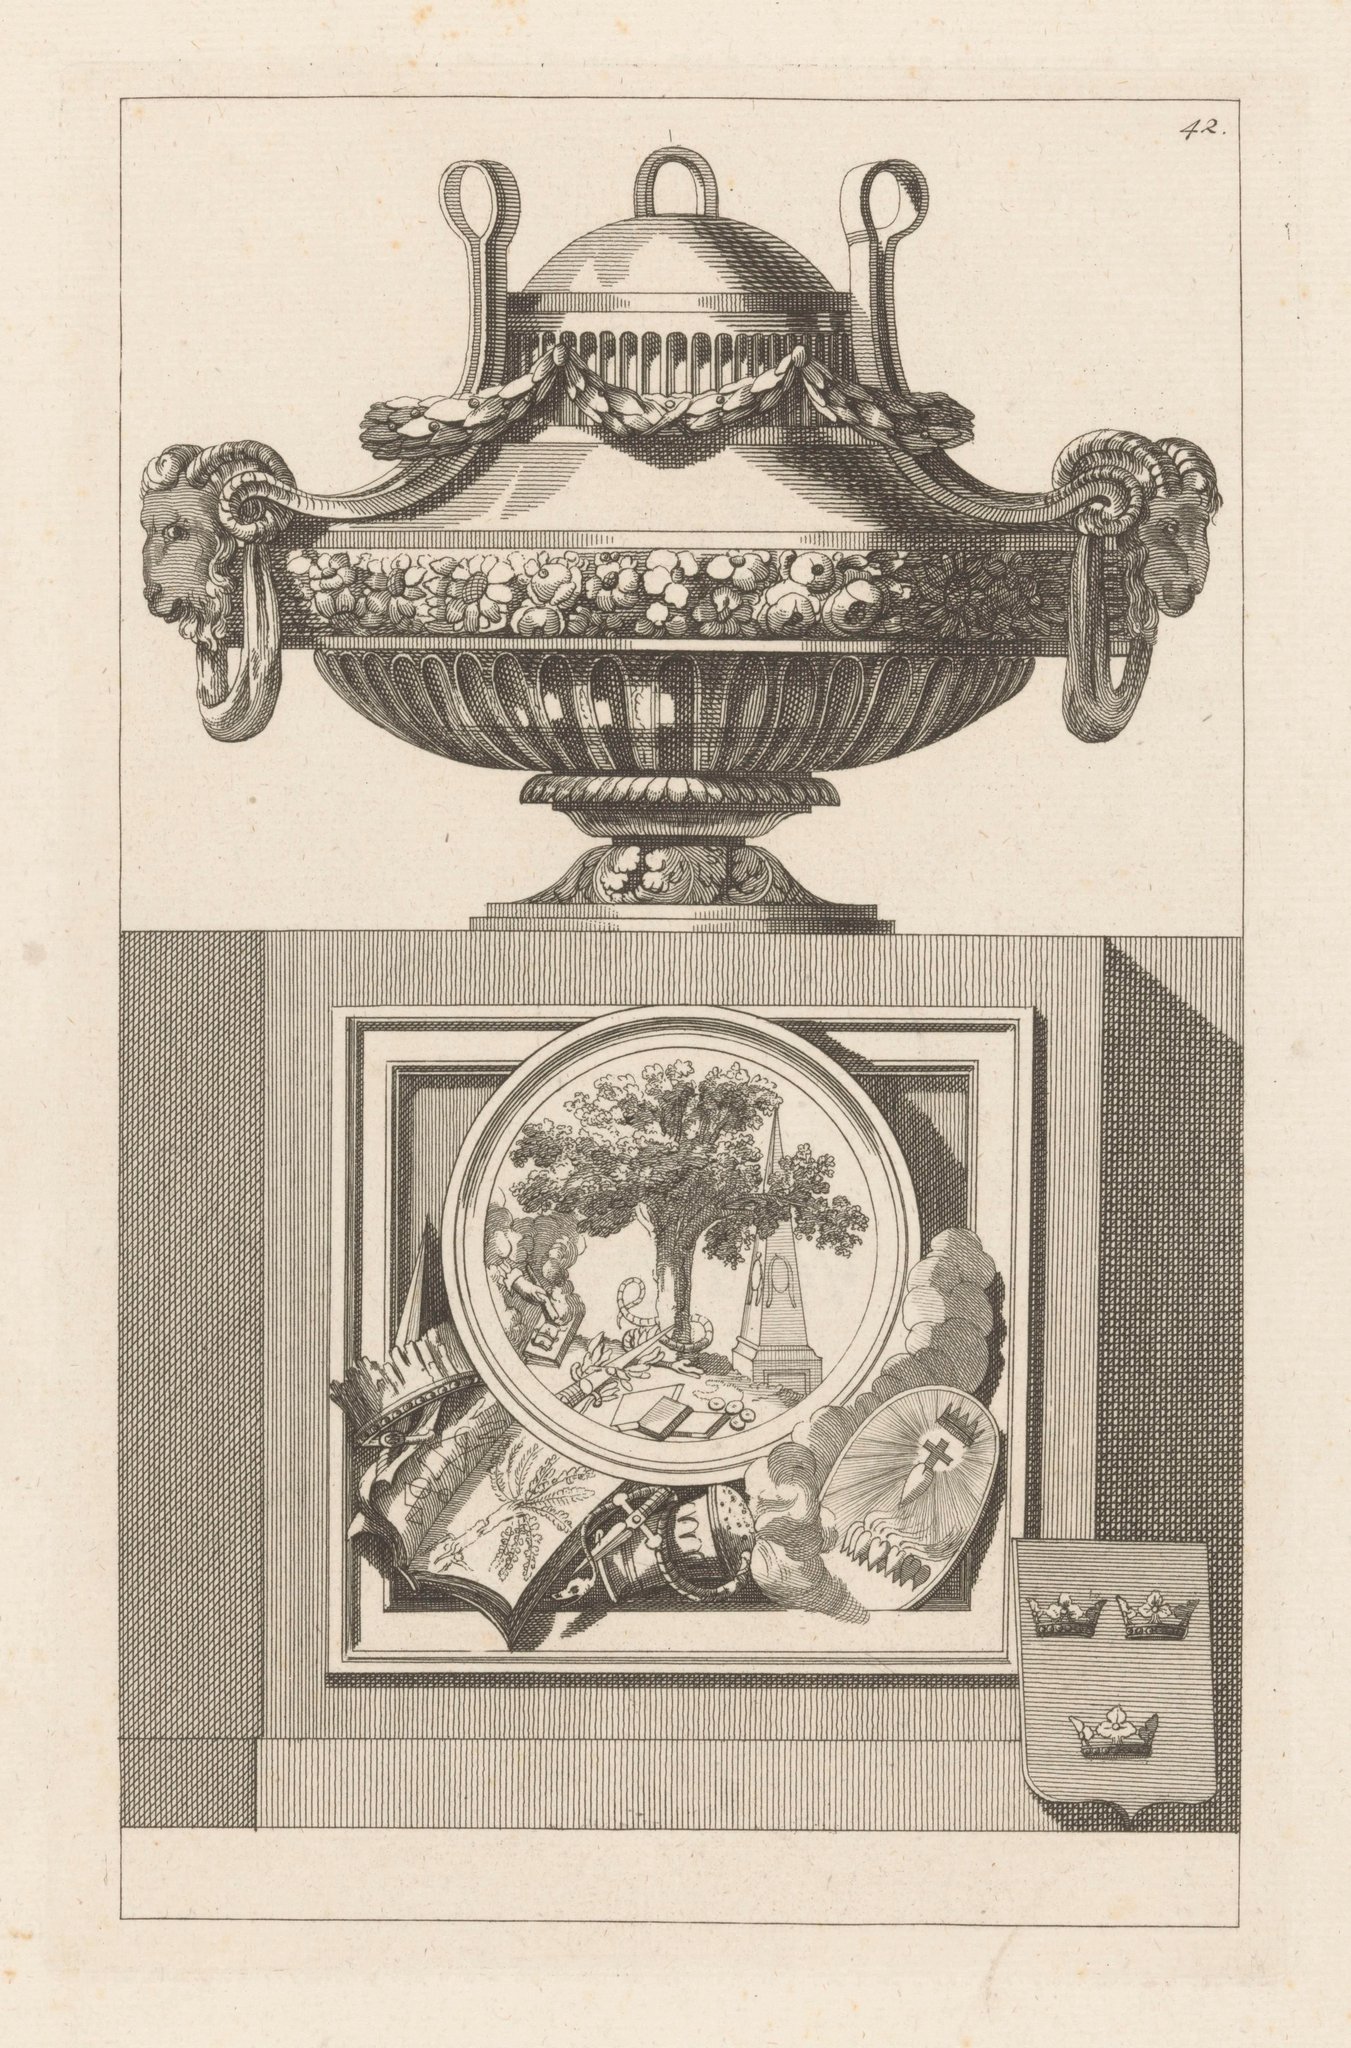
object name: print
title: Vaas met ramskoppen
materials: paper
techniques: engraving, etching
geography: paris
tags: ram's head ~ ornament, vase ~ ornament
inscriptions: collector's mark: Lugt 2760, collector's mark: Lugt 2228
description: Een geornamenteerde vaas met ramskoppen. Daaronder een tablet met een kroon, een boek, een rookvat, een schild met brandende harten en een rond medaillon met een boom en een obelisk. Rechts boven 42 genummerd.